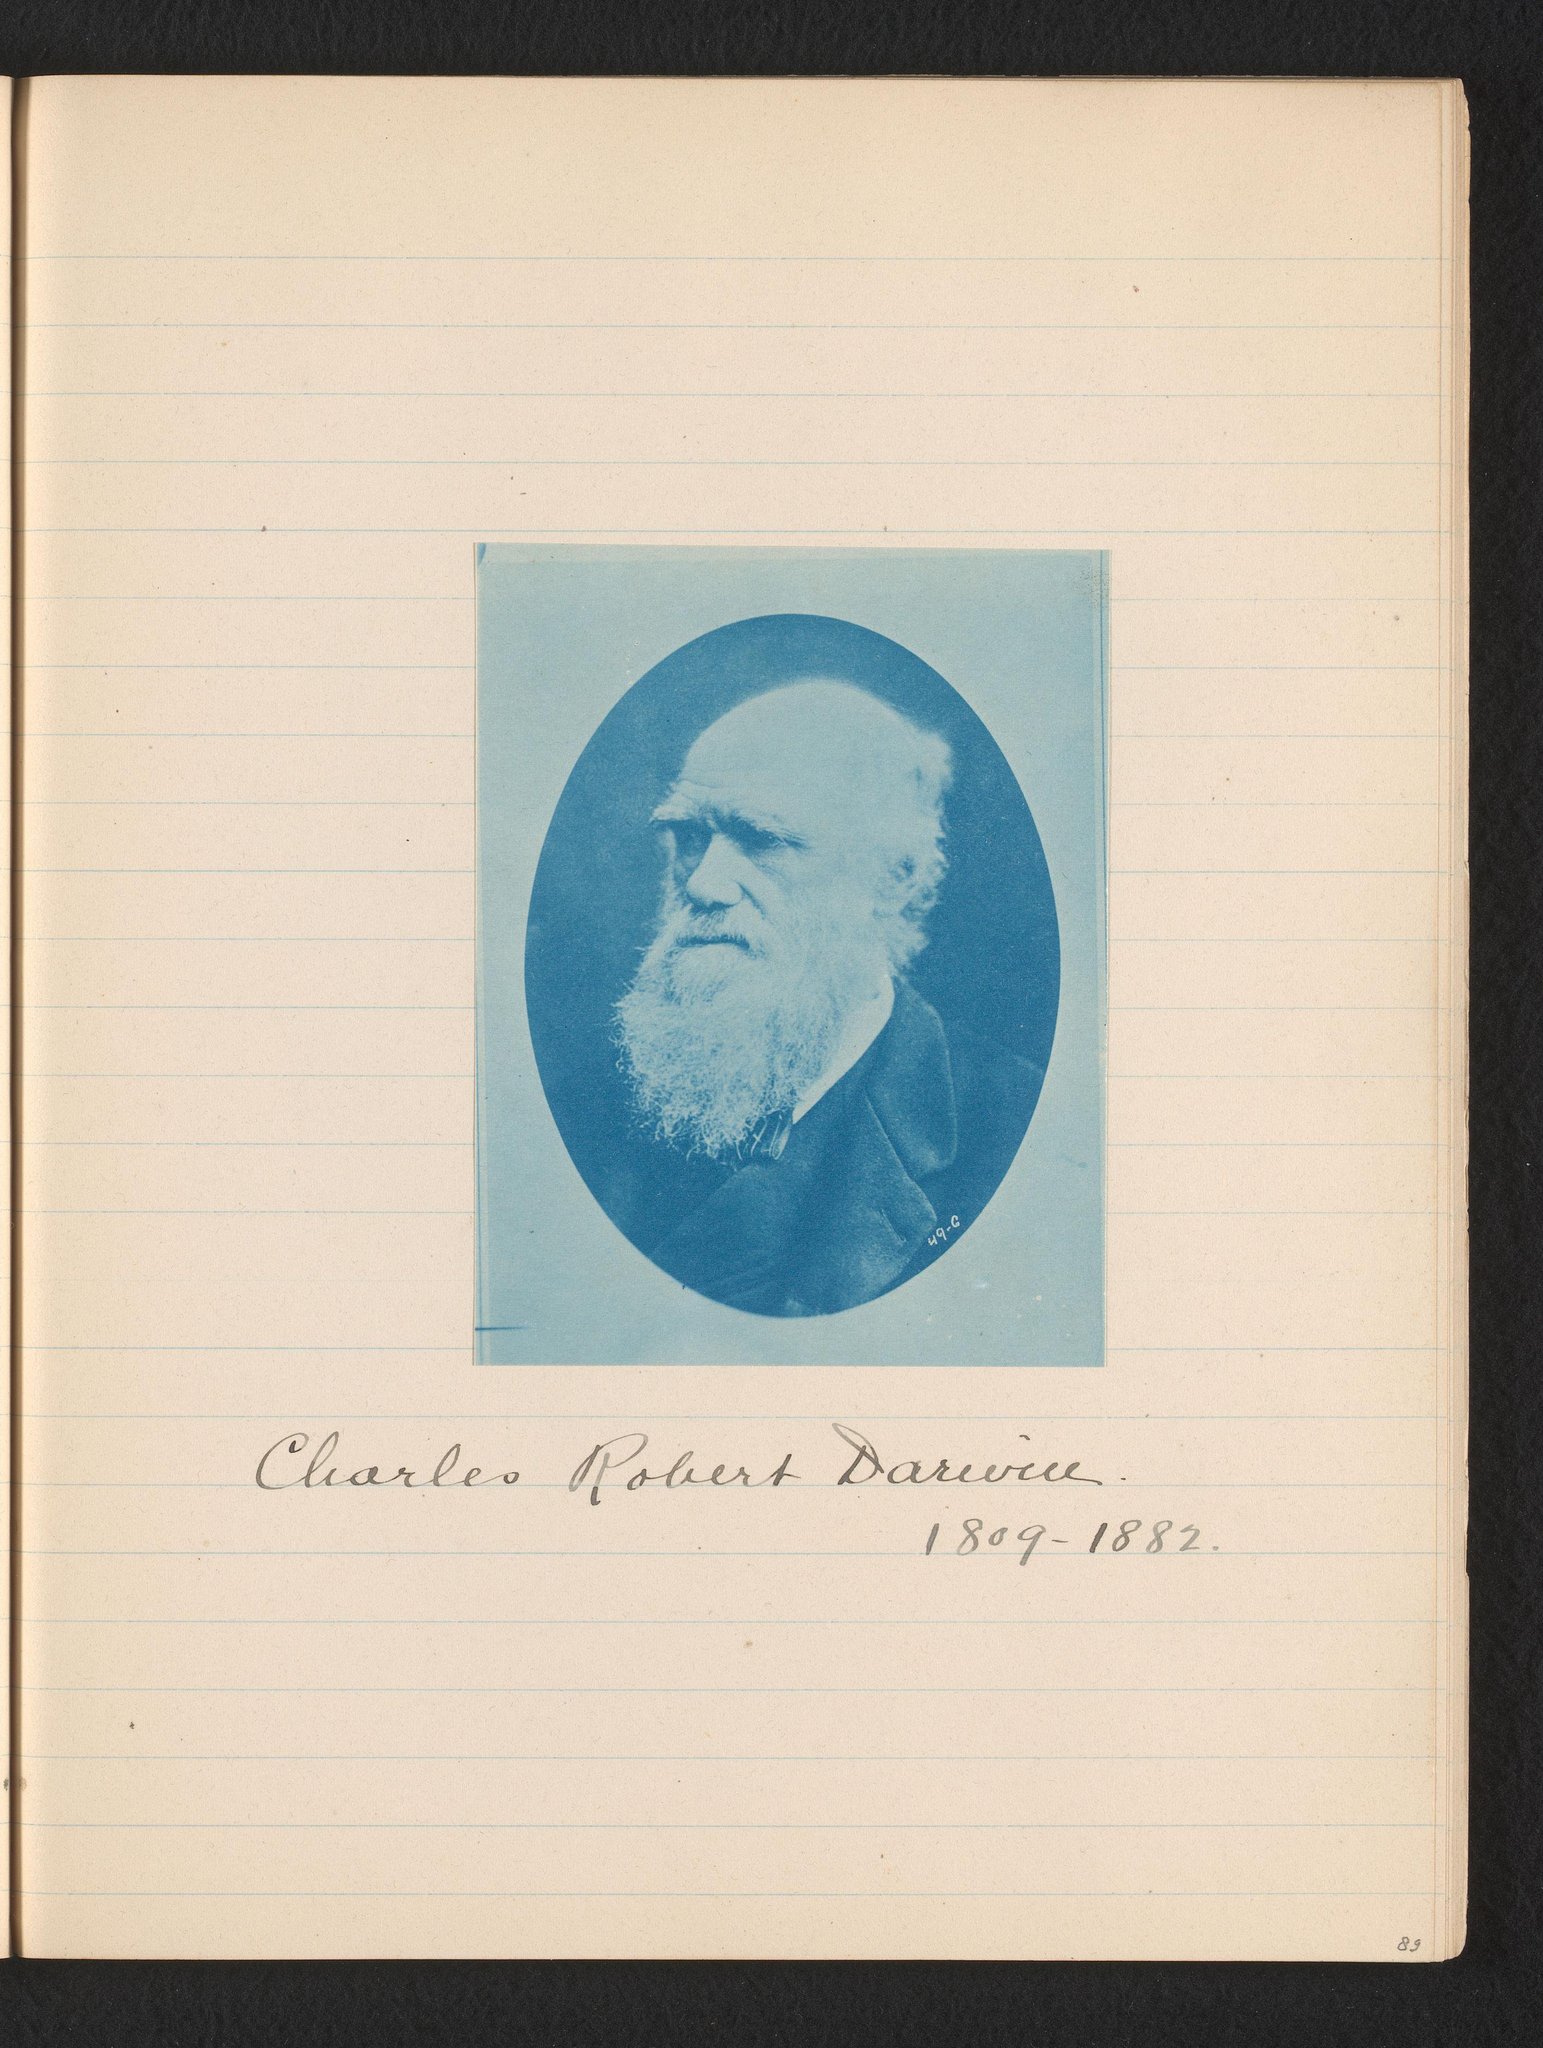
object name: album leaf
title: Portret van Charles Darwin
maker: Anonymous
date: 1868-1882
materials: paper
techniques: cyanotype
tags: charles darwin, scholar, philosopher, historical persons